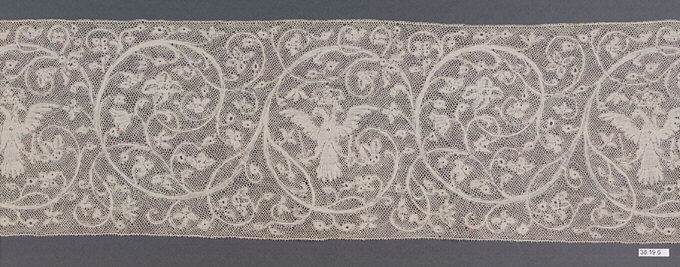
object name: border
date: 1701-1733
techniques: lace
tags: birds